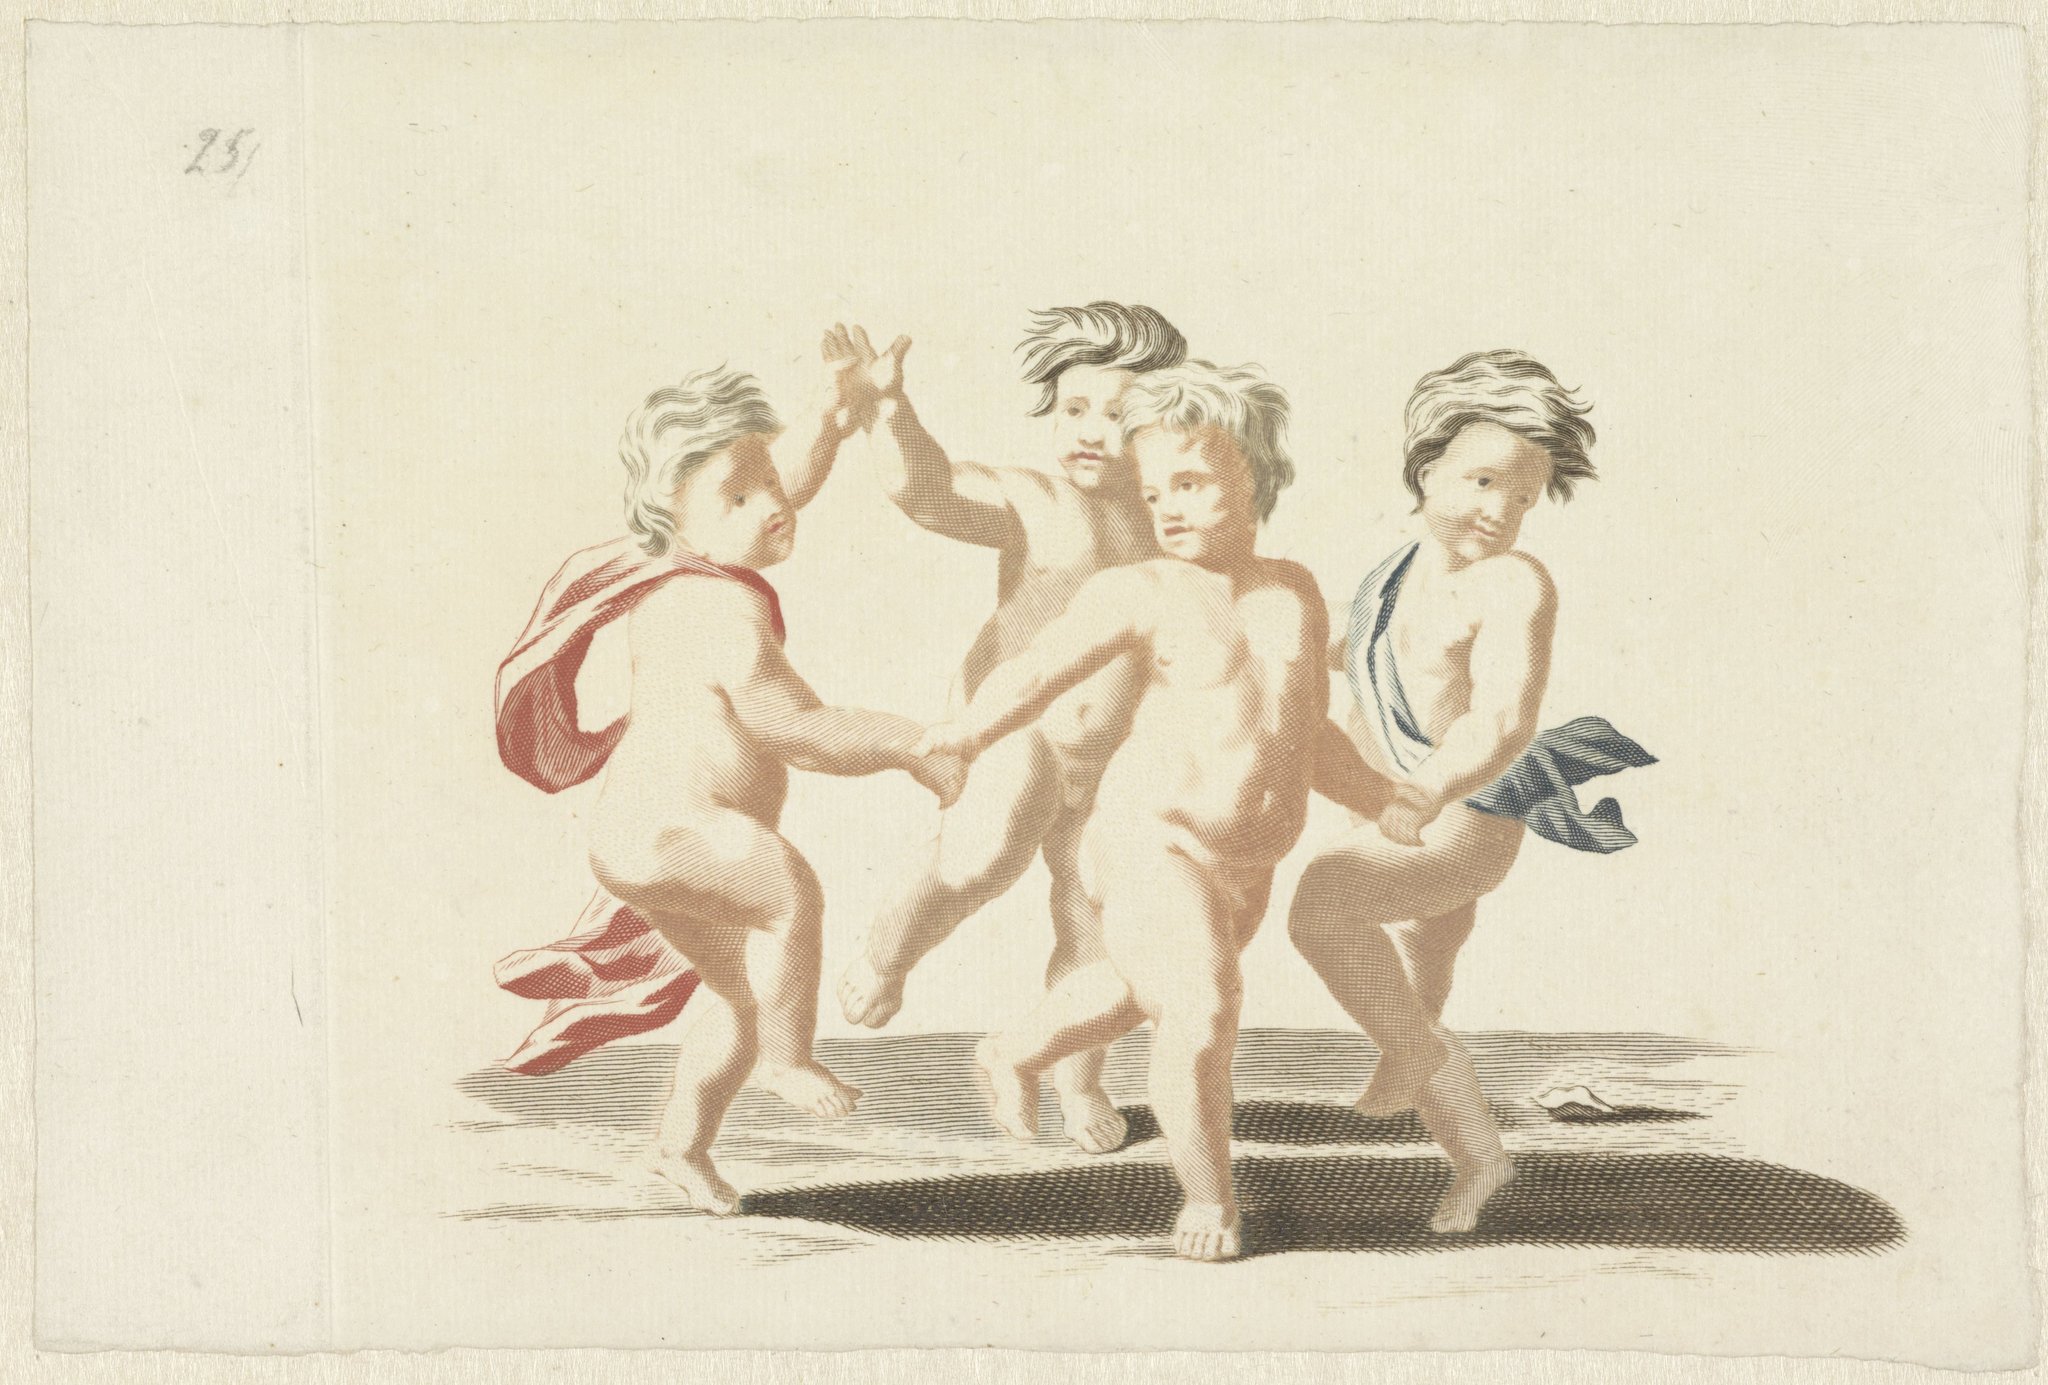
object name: print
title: Vier dansende putti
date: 1688-1698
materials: paper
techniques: printing, engraving, lithography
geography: netherlands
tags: group dancing, cupids: 'amores', 'amoretti', 'putti'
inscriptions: collector's mark: Lugt 2228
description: Vier putti dansen hand in hand in een kring.